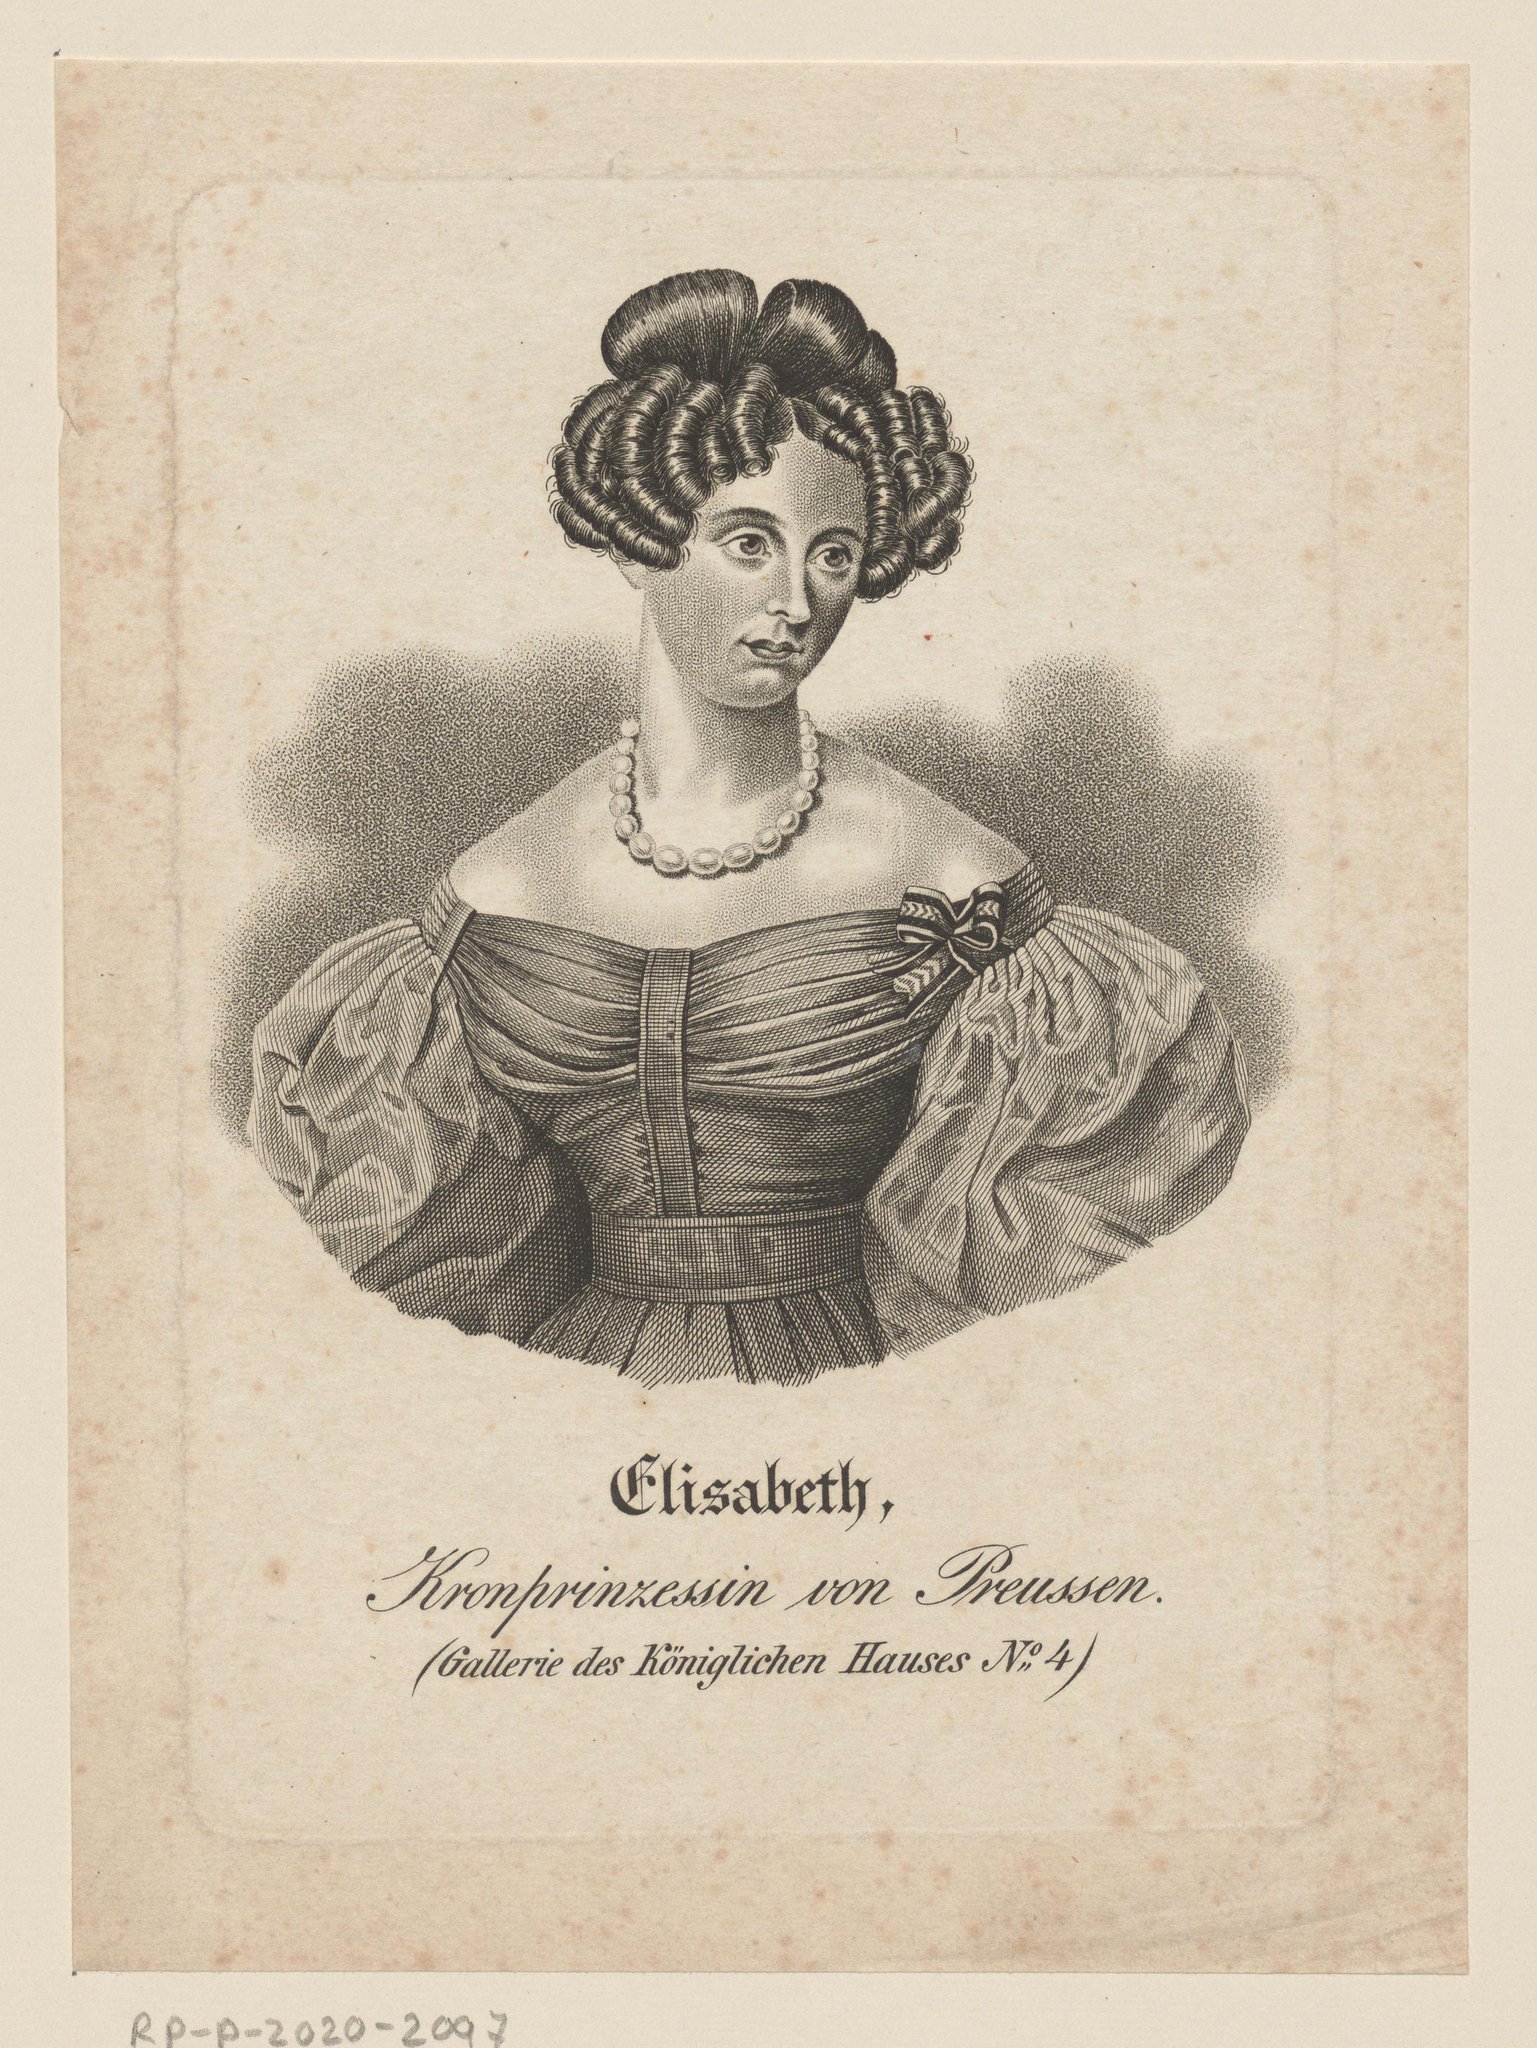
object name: print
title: Portret van Elisabeth Ludovika van Beieren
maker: Anonymous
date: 1823-1840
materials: paper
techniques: engraving, etching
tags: historical persons - bb - woman, pearl; pearl necklace